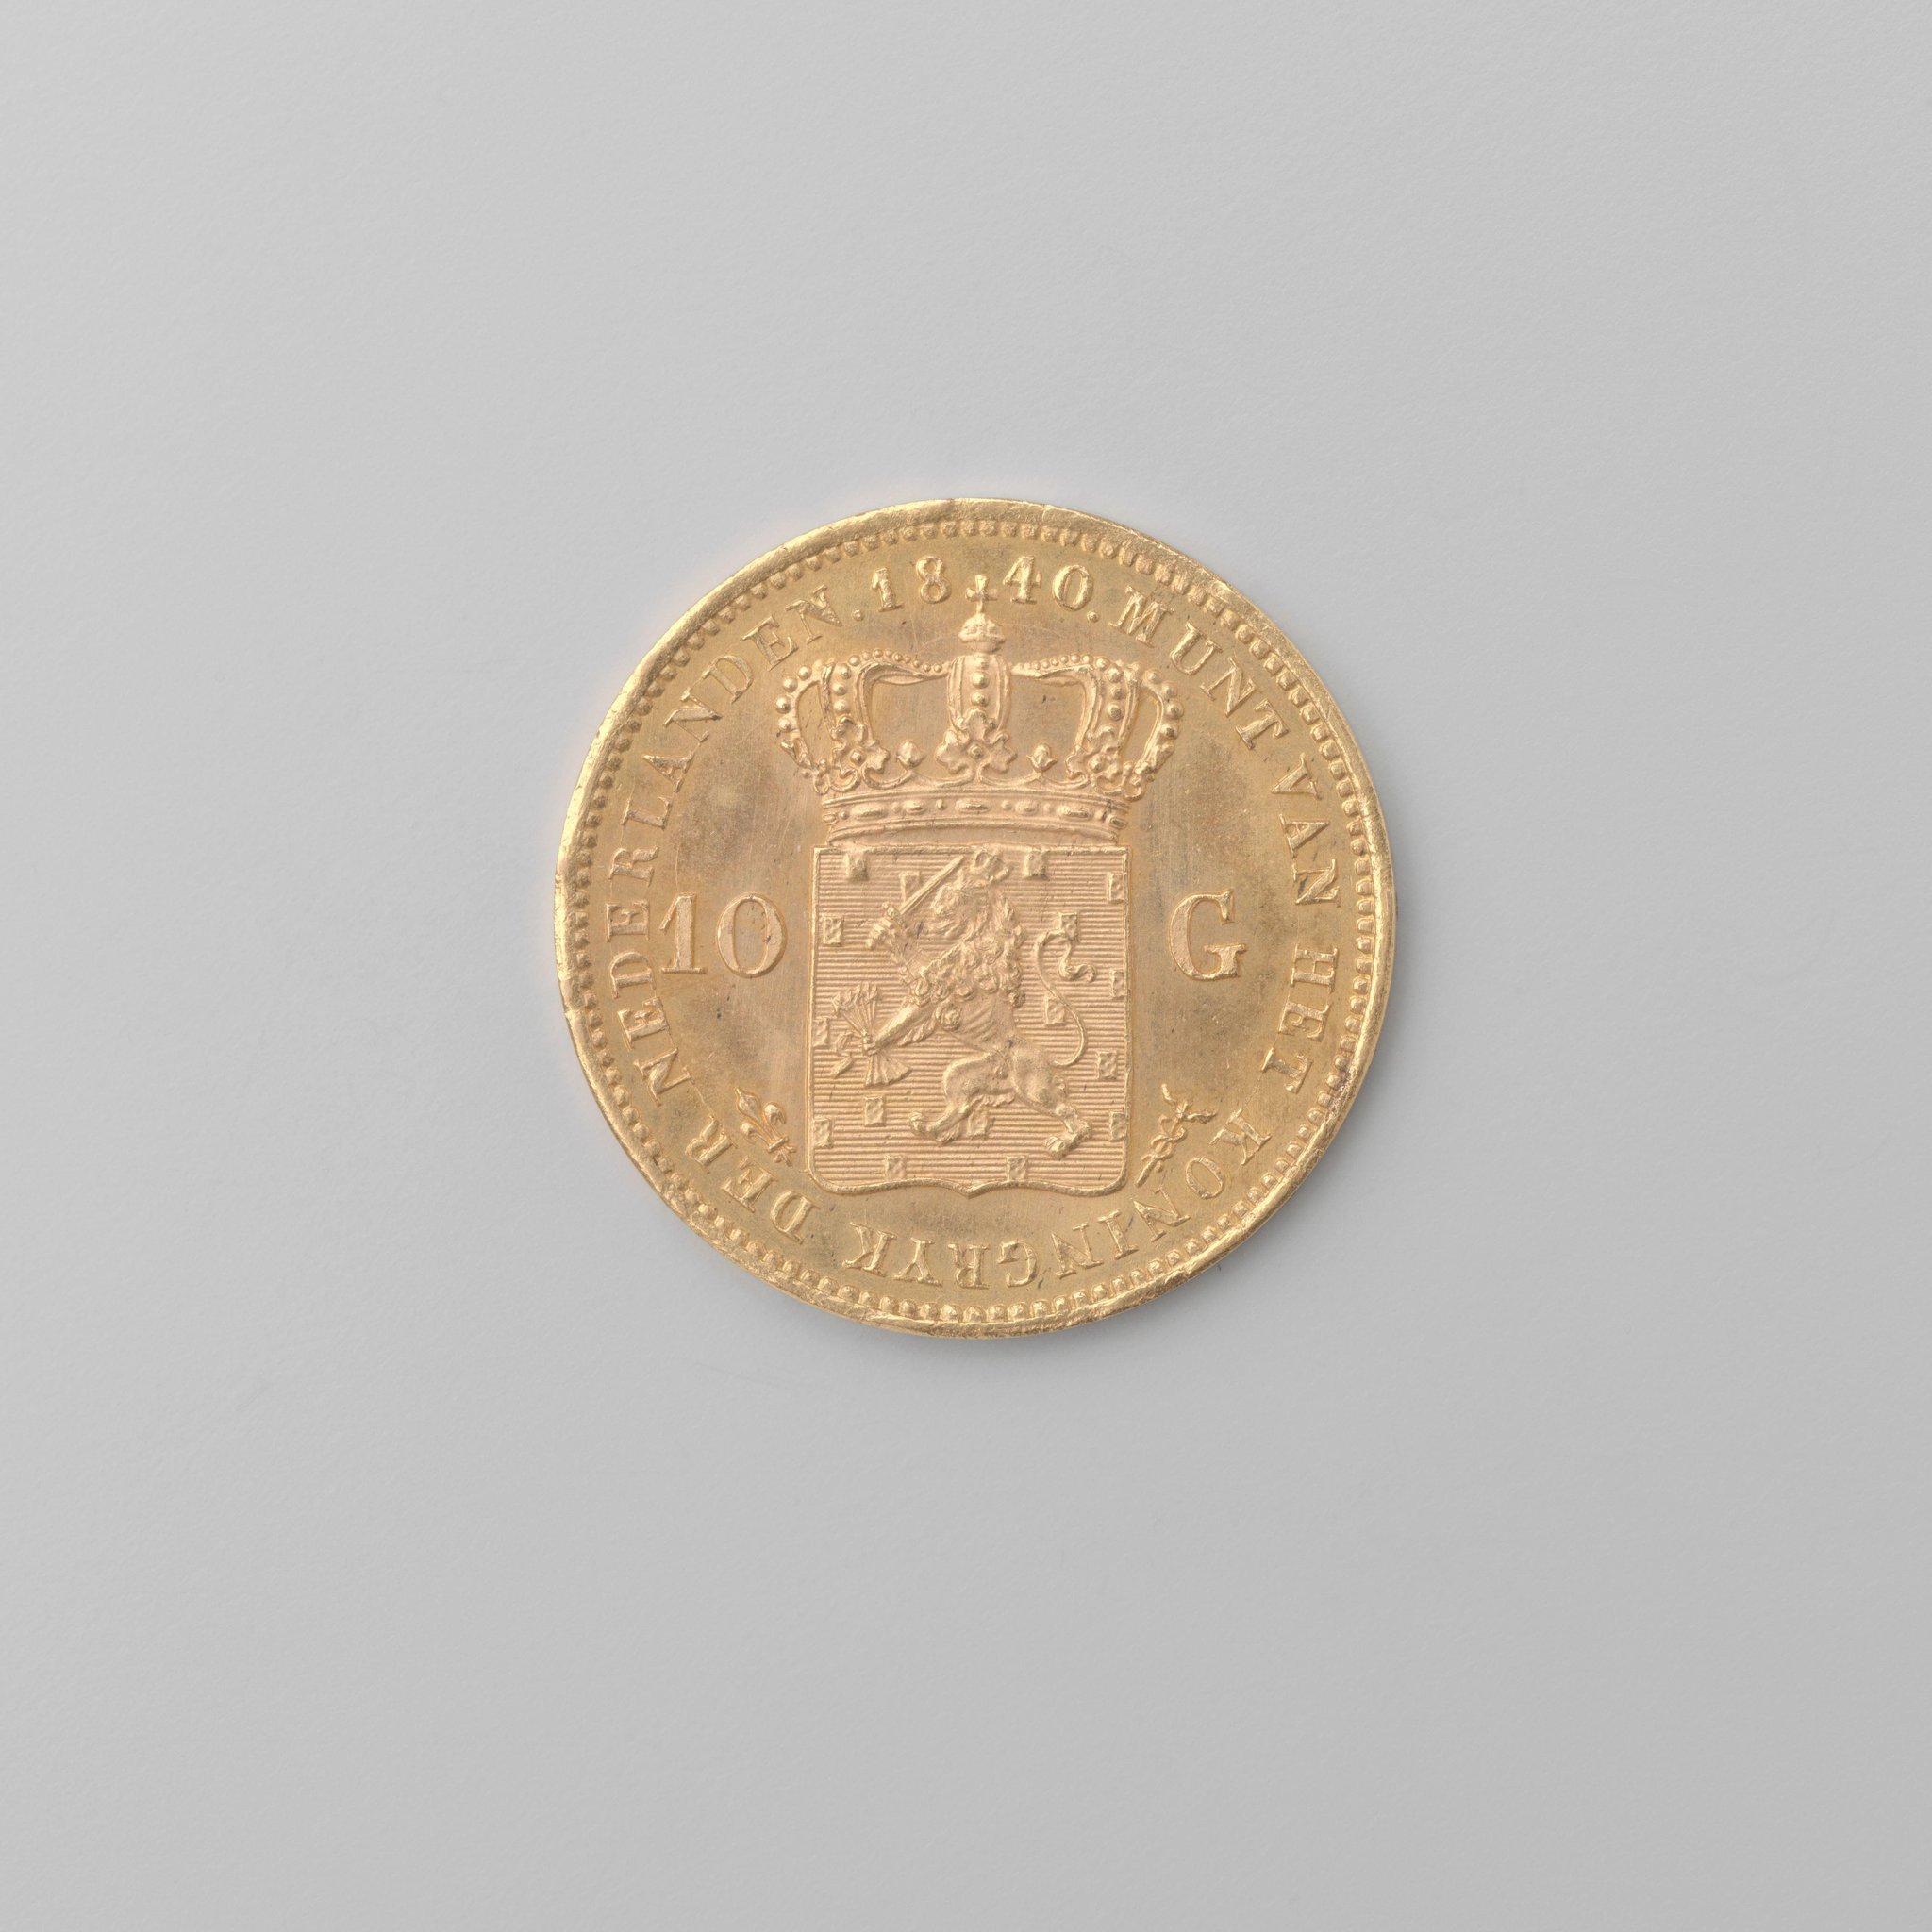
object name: coin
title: Nederland, 10 gulden, 1840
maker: william i of the netherlands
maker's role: koning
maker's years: 1772-1843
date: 1840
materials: gold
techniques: striking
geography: utrecht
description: Gouden munt. Voorzijde: borstbeeld naar links. Keerzijde: tussen waarde-aanduiding 10 G gekroond rijkswapenschild. Jaartal boven kroon. Randschrift.